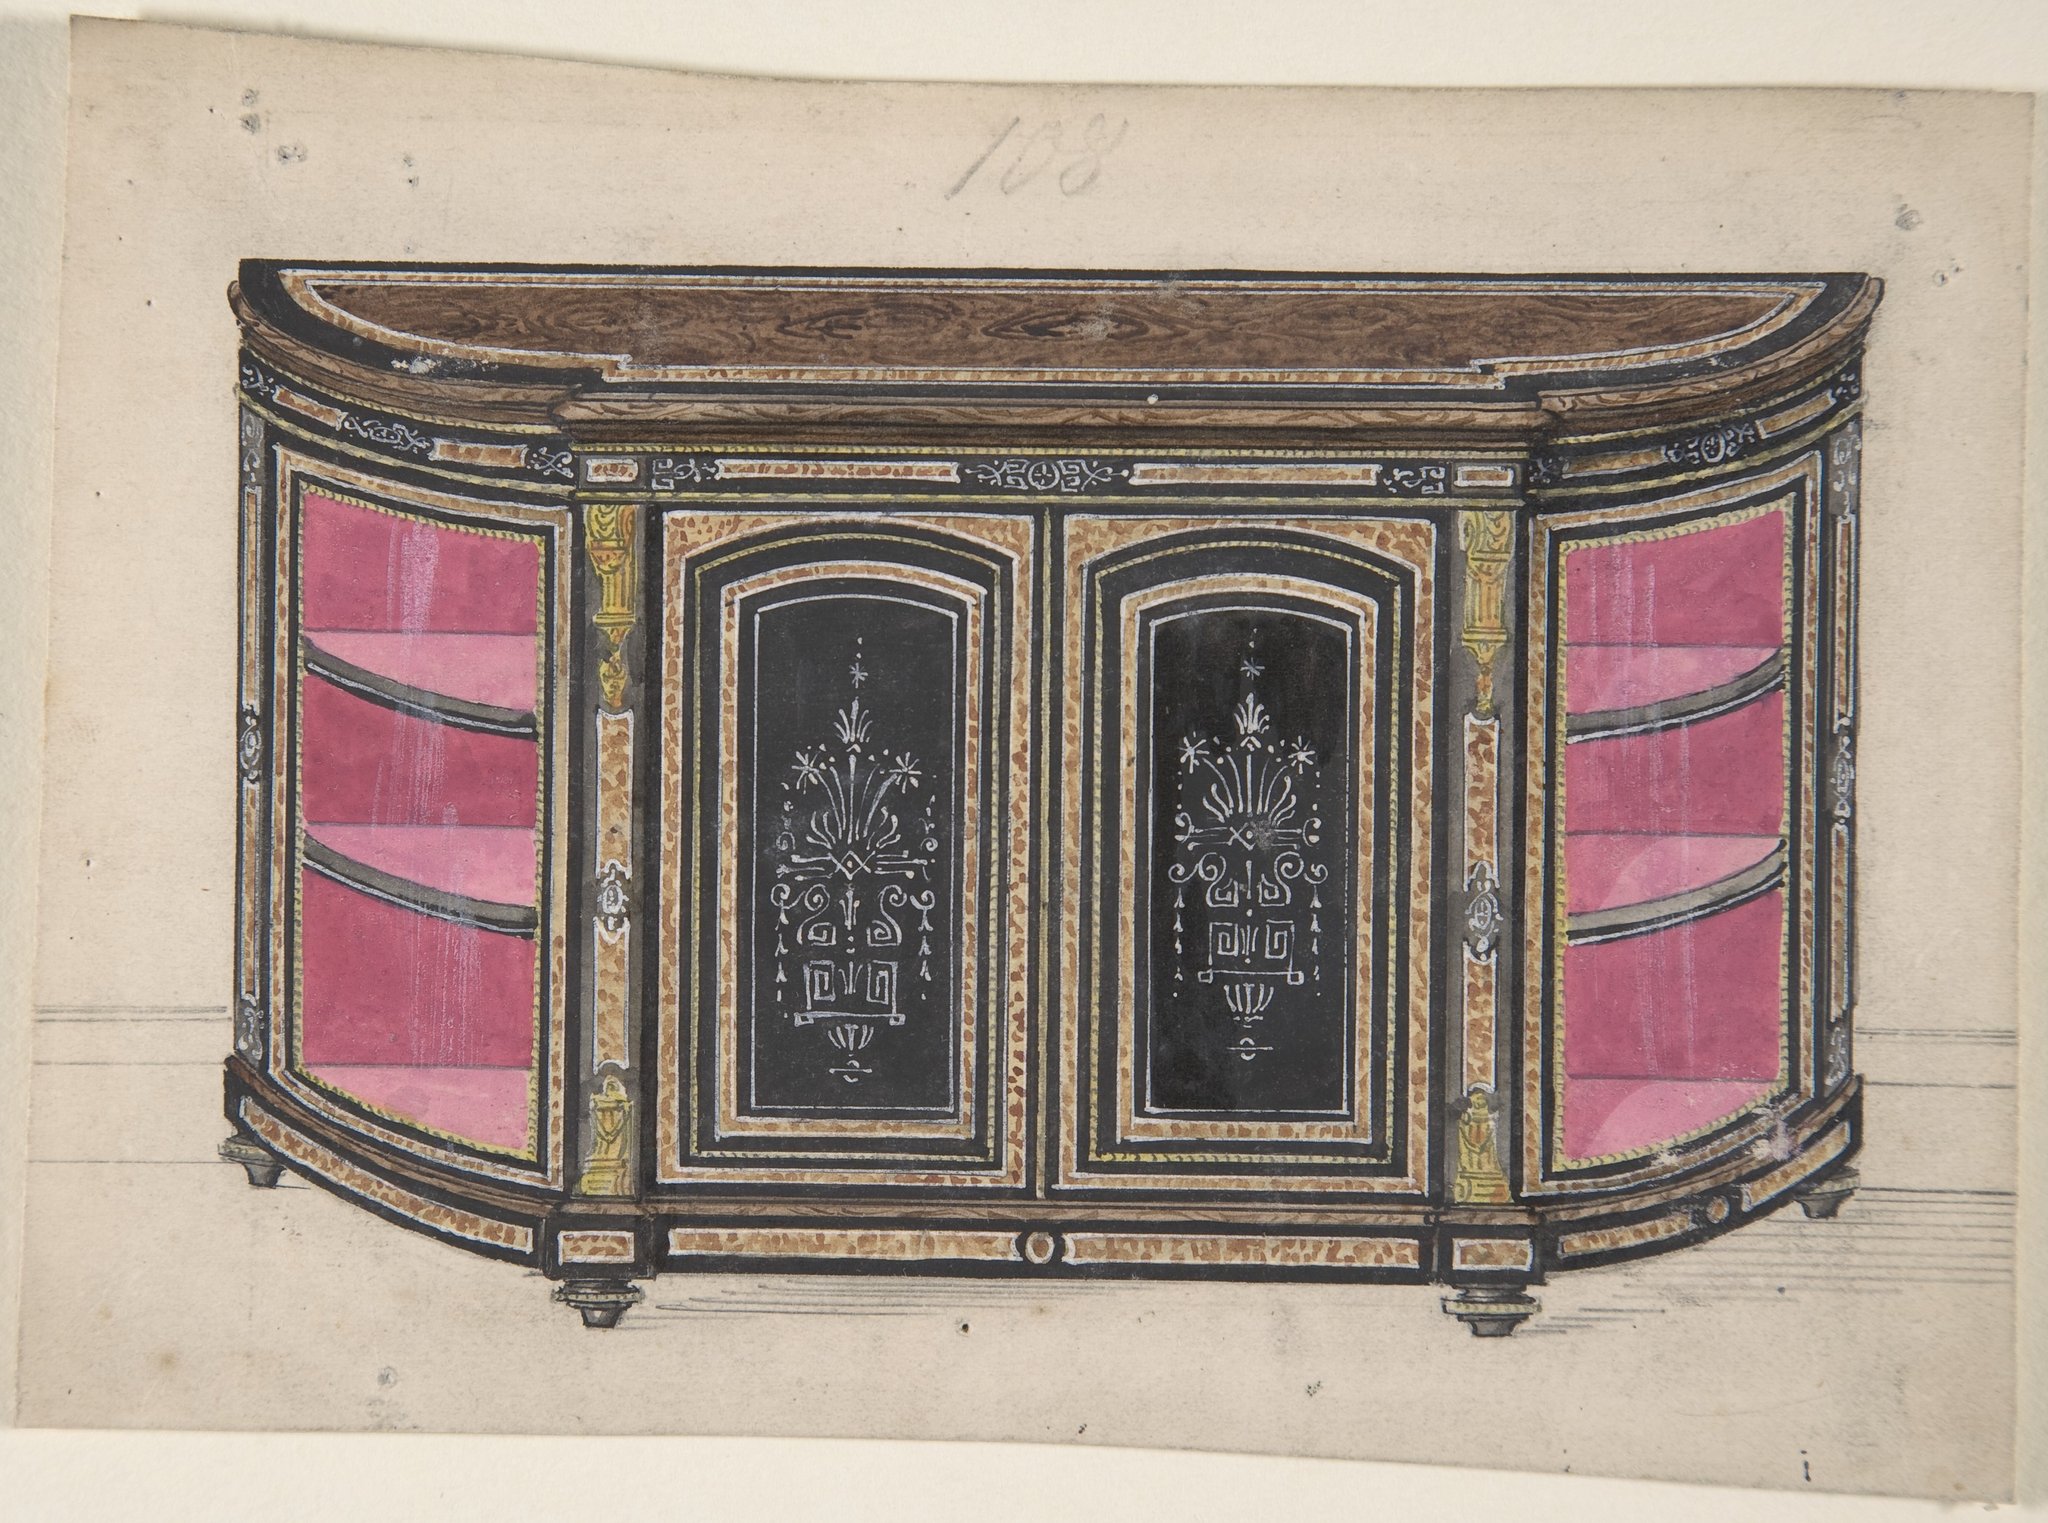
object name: drawing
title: Cabinet Design with Black Doors and Red Interior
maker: anonymous, british, 19th century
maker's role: artist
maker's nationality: british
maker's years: 1800-1900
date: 1801-1900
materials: ink, watercolor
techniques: pen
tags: cabinets